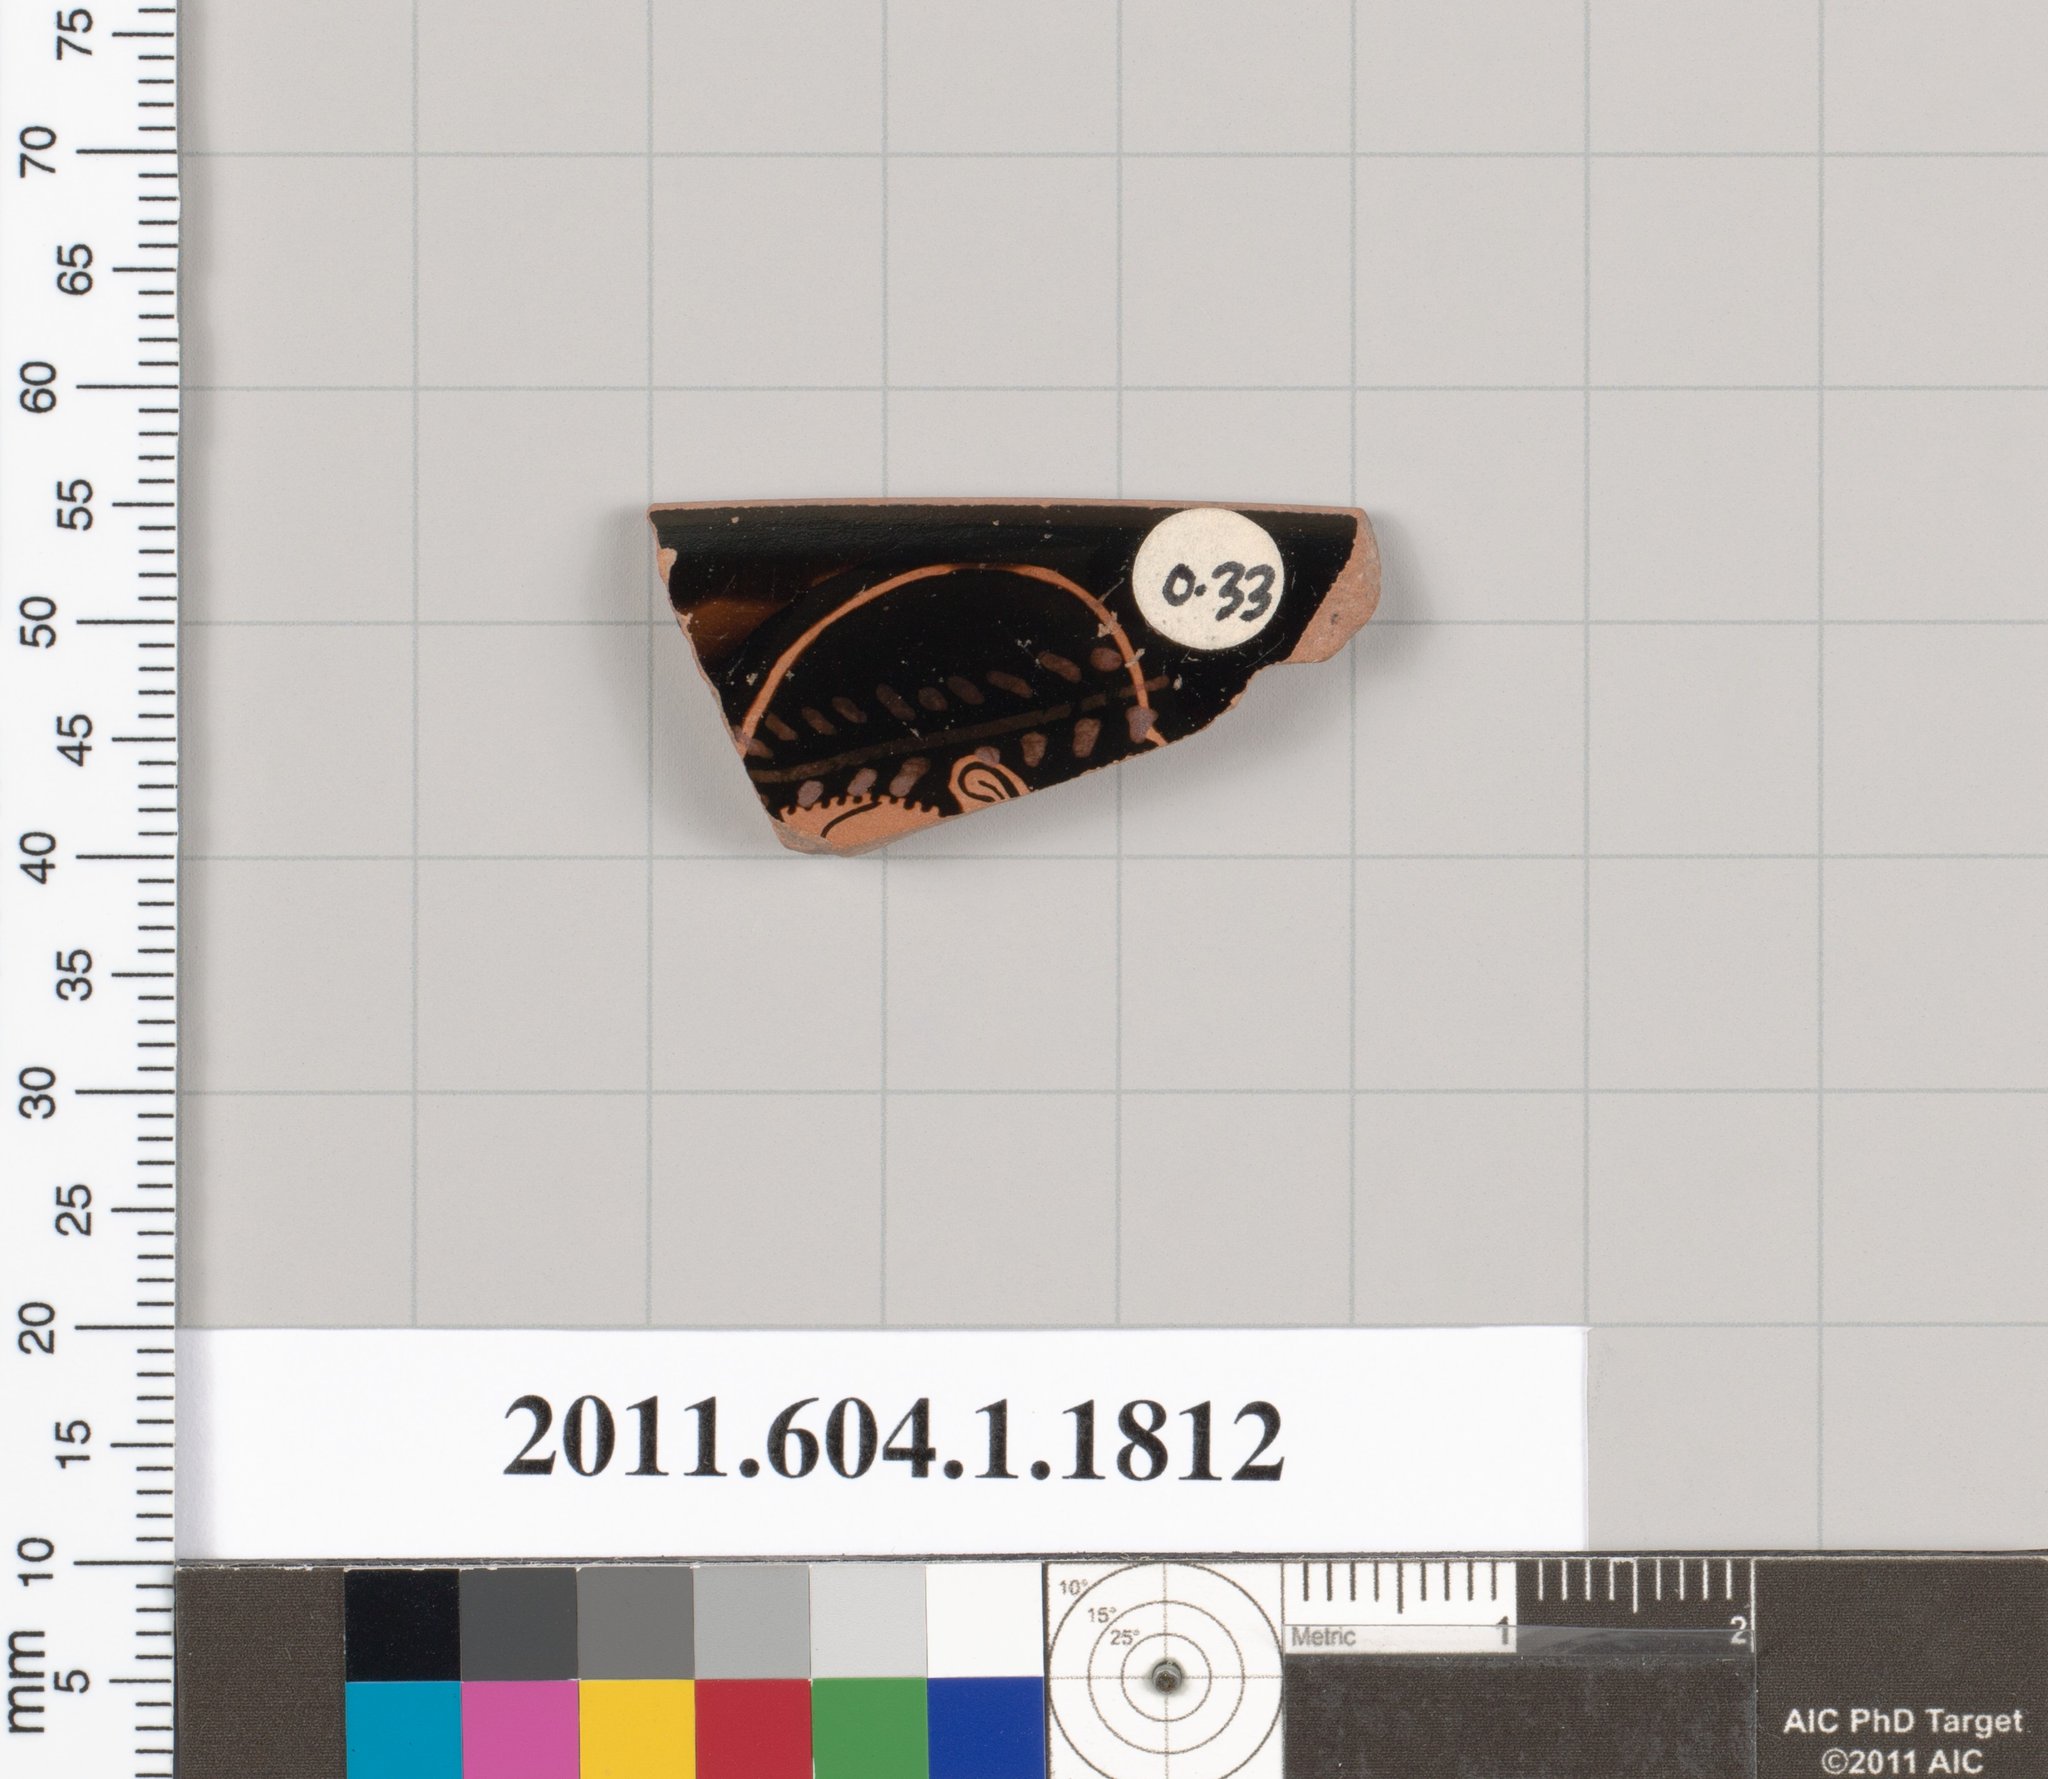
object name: kylix fragment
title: Terracotta rim fragment of a kylix (drinking cup)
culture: greek, attic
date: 490-480 BCE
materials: terracotta